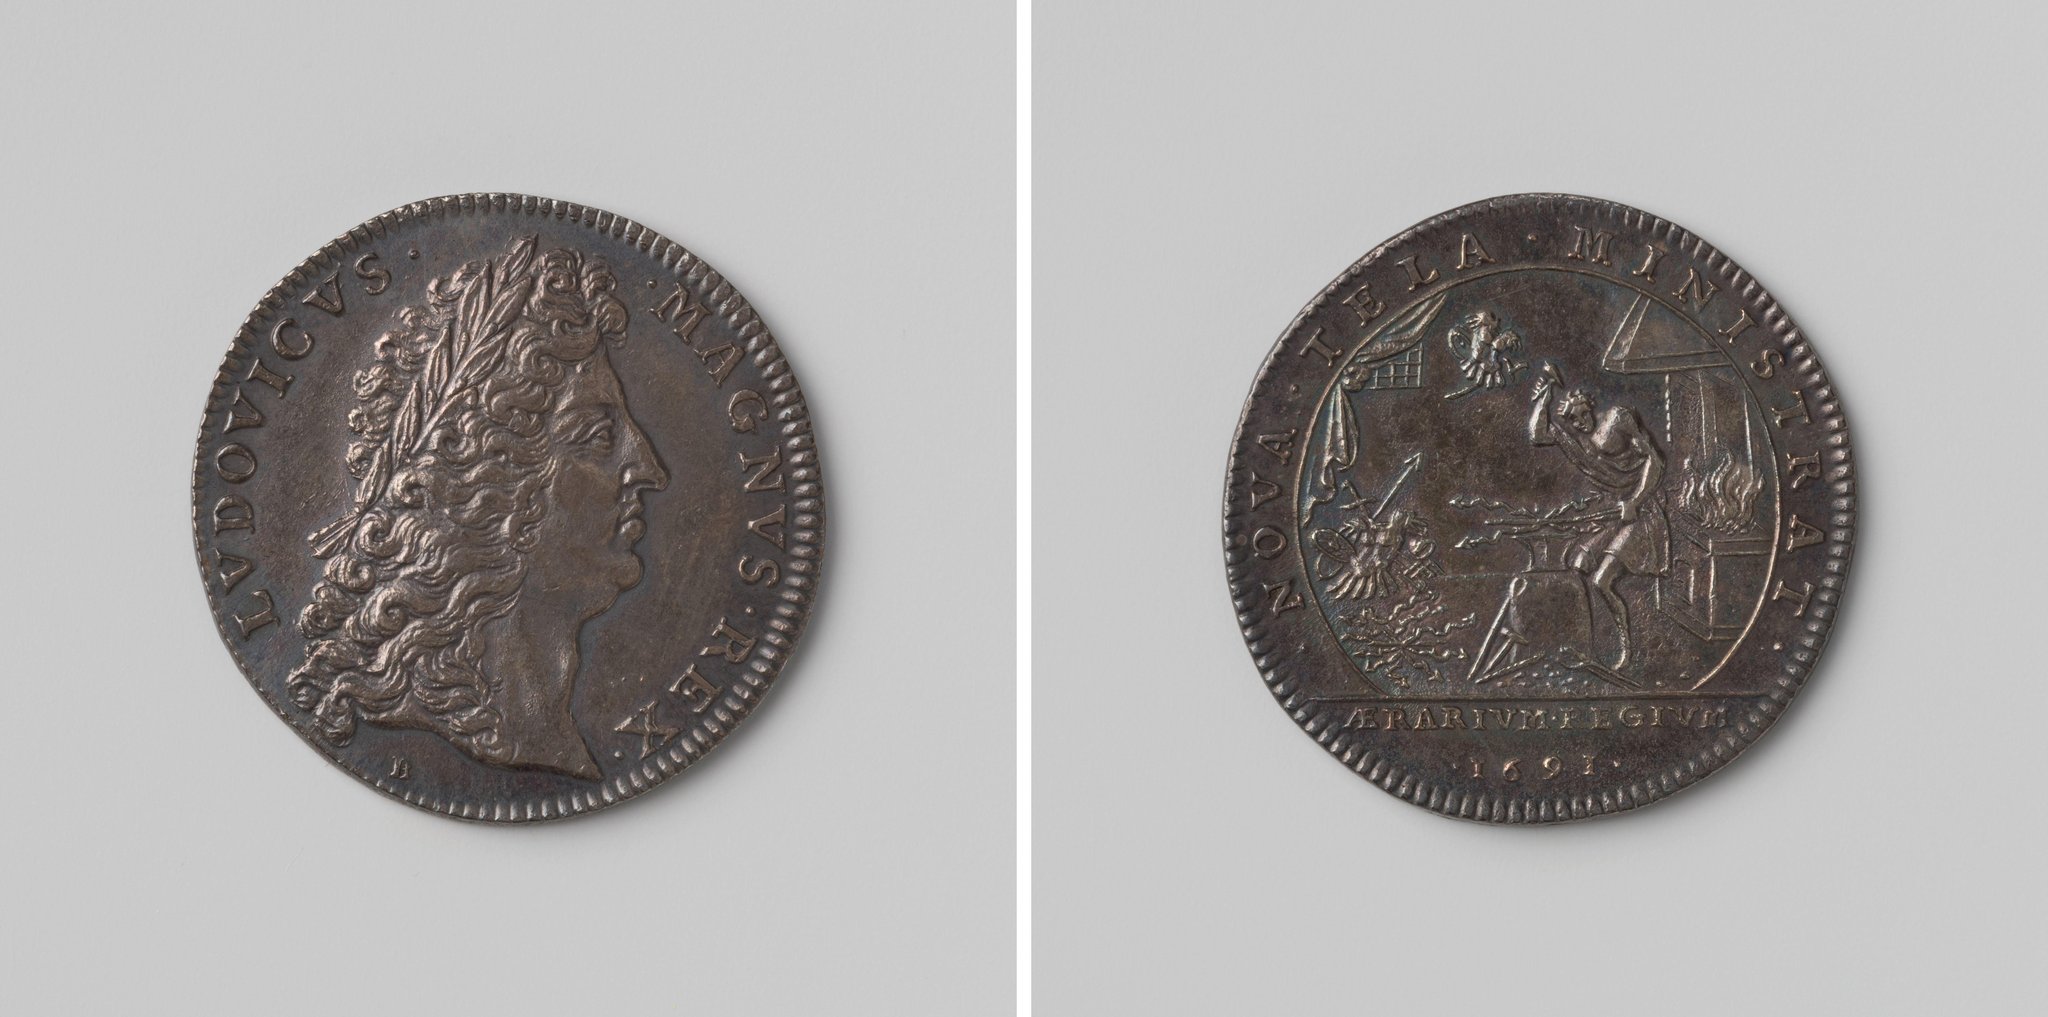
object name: medal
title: Krijgstoerustingen van Lodewijk XIV, koning van Frankrijk, rekenpenning geslagen op last van de koninklijke schatkamer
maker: monogrammist b (frankrijk)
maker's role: medailleur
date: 1691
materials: copper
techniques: striking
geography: france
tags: lodewijk xiv (koning van frankrijk)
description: Koperen penning. Voorzijde: buste van Lodewijk XIV naar rechts, met lauwerkrans, binnen omschrift. Keerzijde: Vulcanus bezig met smeden van bliksems en wapenuitrusting voor Jupiter, binnen omschrift; afsnede: opschrift